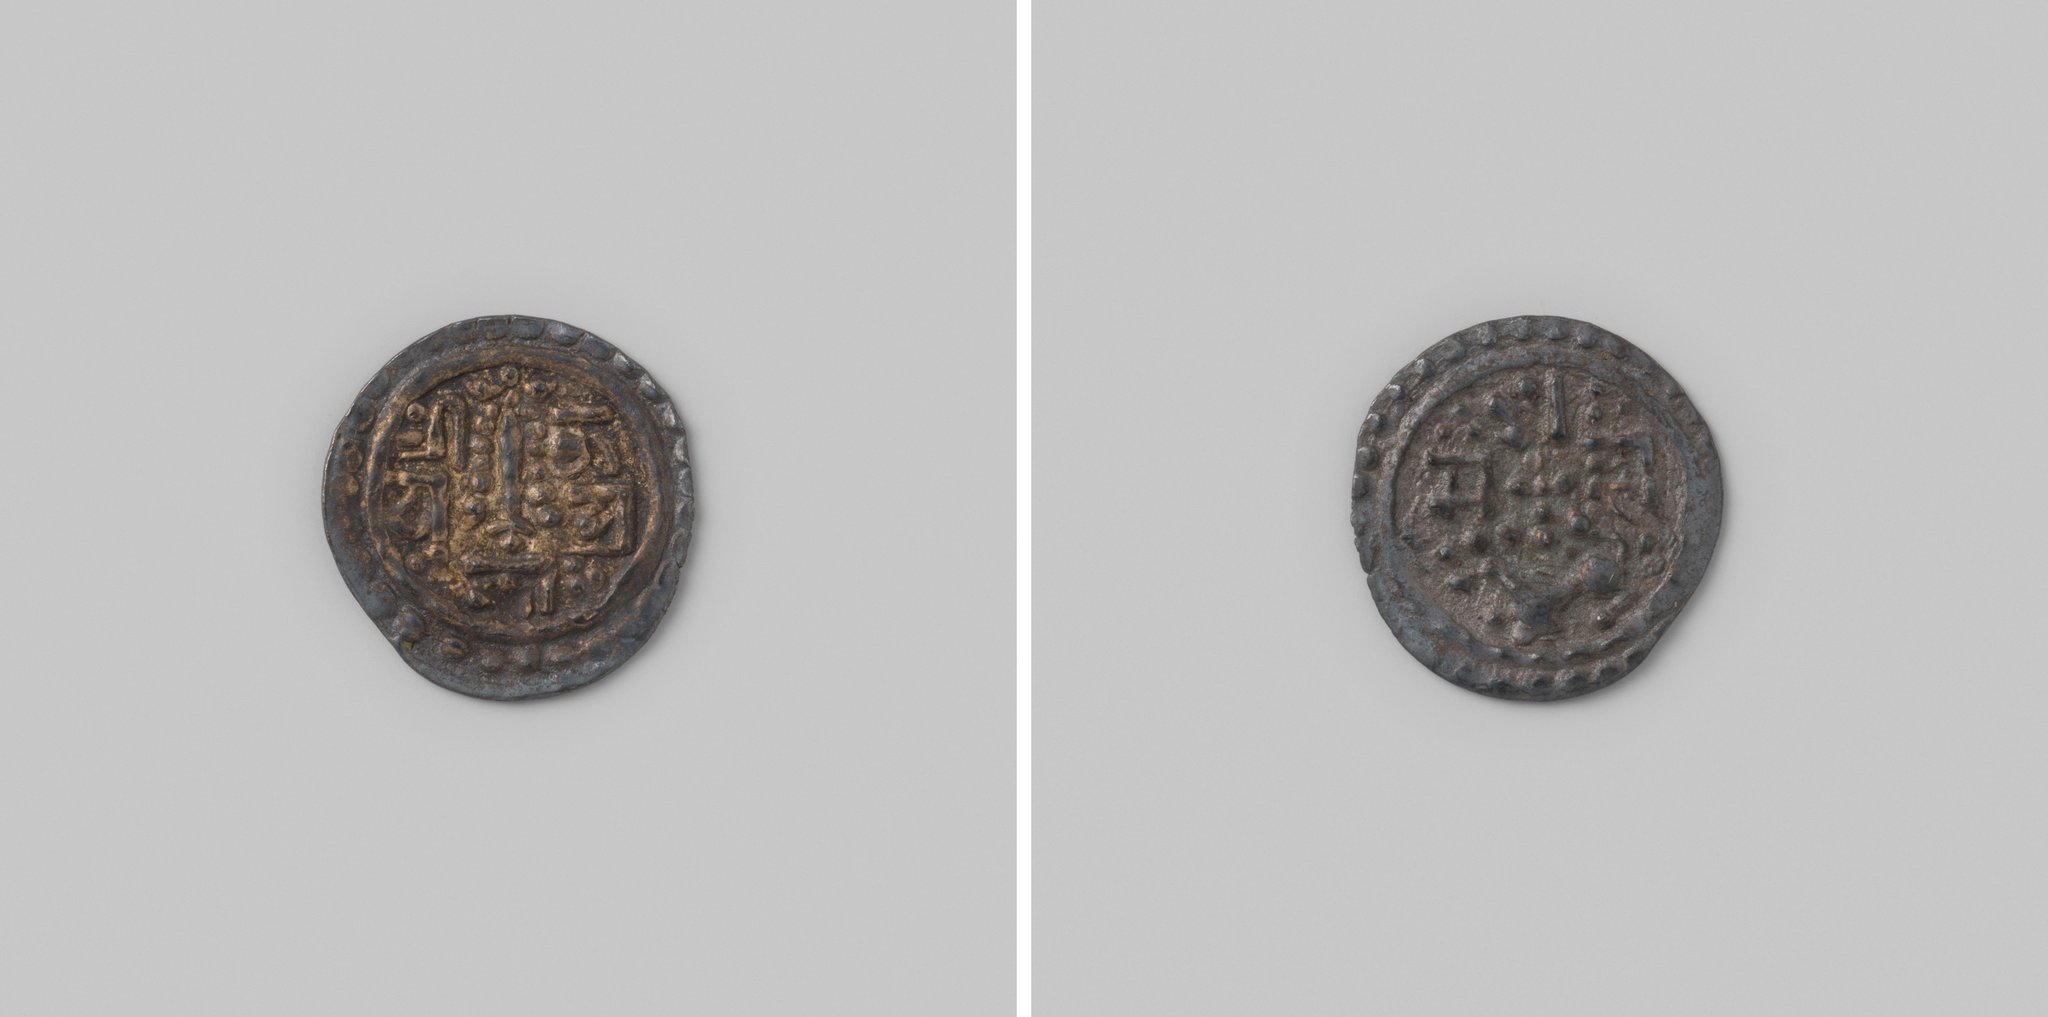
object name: halve anna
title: ½ anna uit Nepal van Jaya Prakasa Malla van Katmandu, 1732 - 1768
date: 1732-1768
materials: silver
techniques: striking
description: Zilveren munt. Voorzijde: een stupa, waaromheen tekens in Nagari-schrift. Keerzijde: figuur, waaromheeen tekens in Nagari-schrift. Gladde rand.